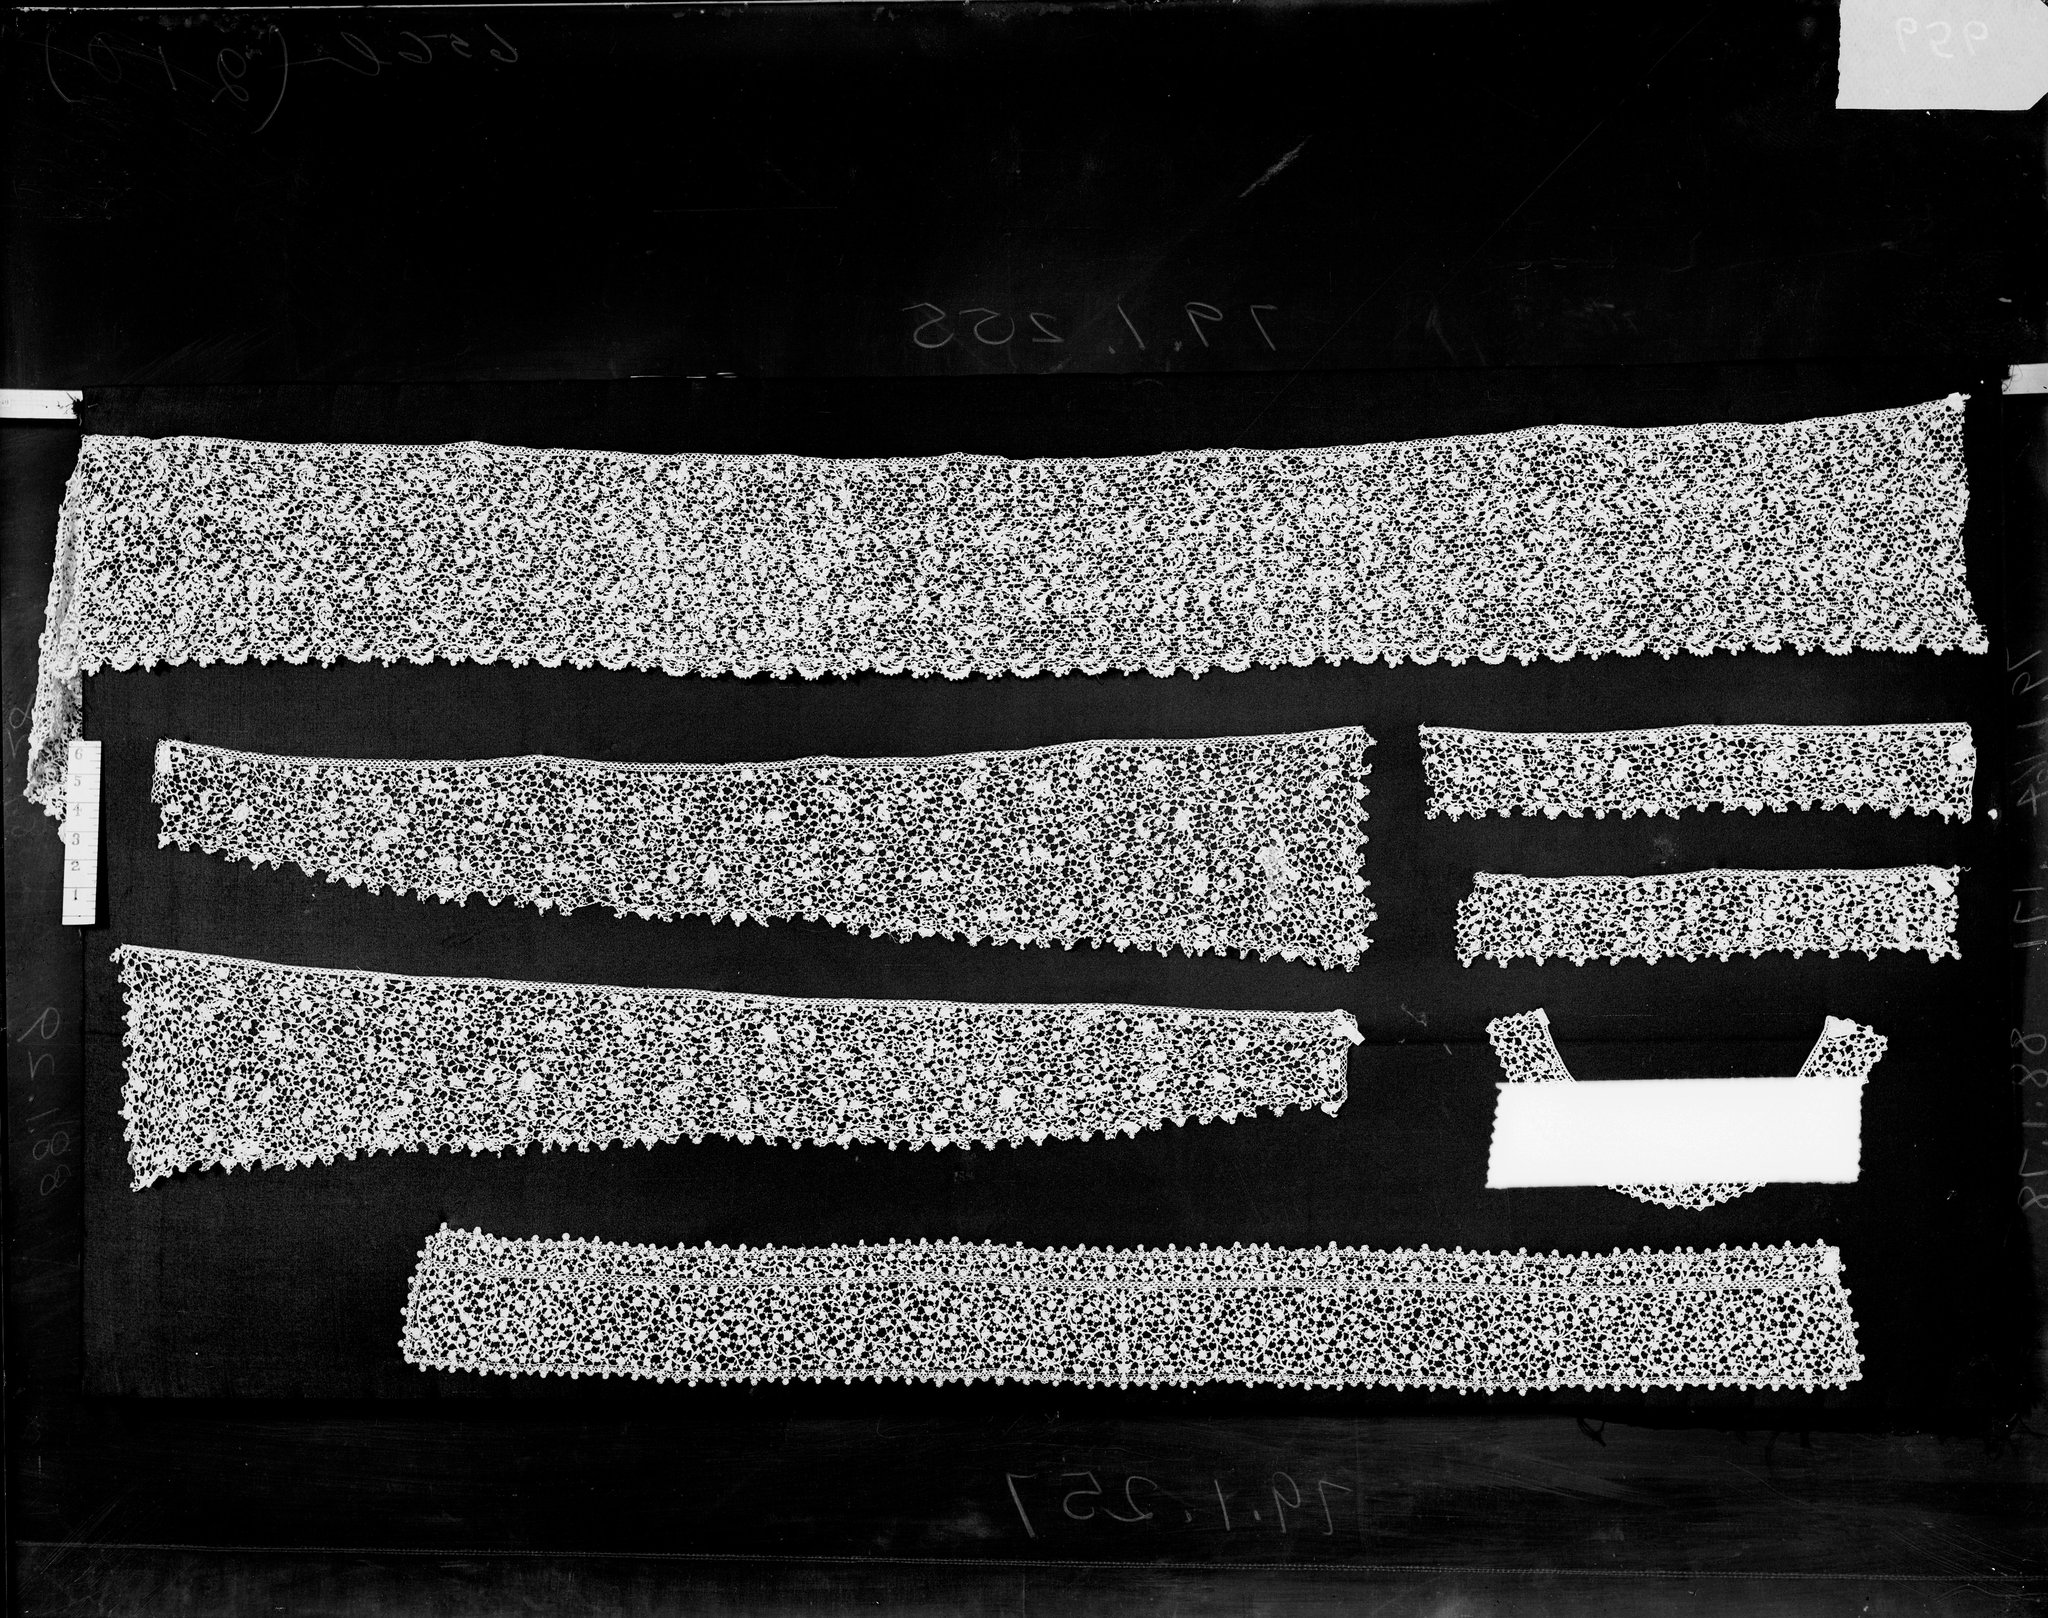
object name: strip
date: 1701-1733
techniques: lace